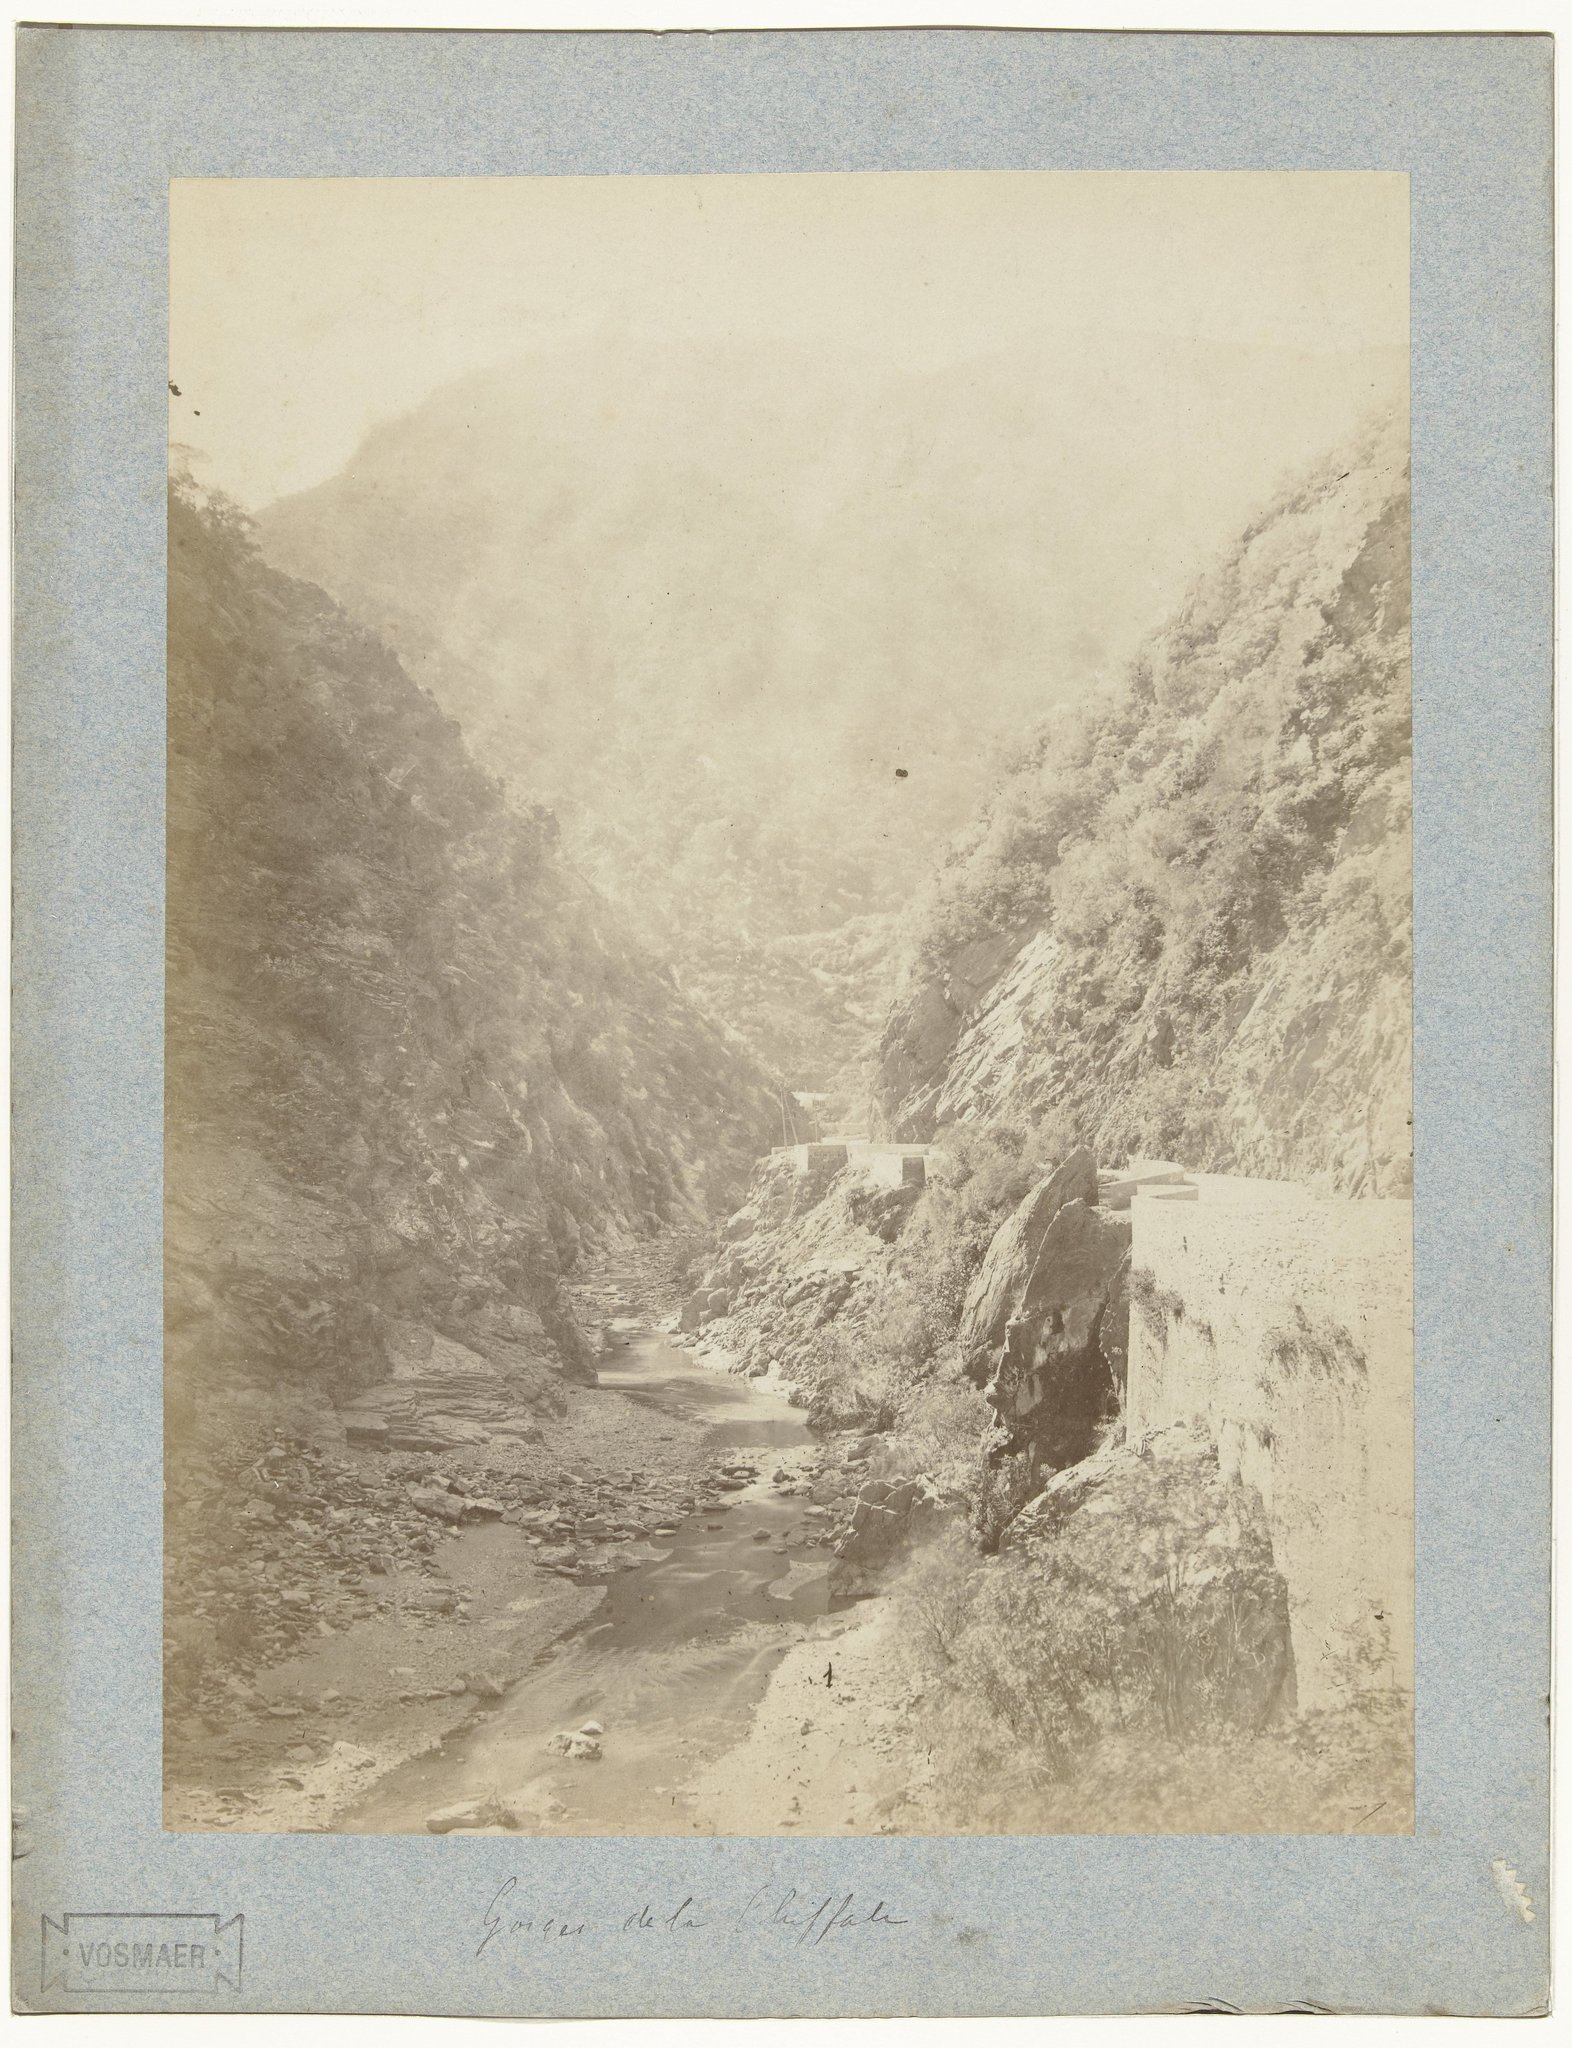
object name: photograph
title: Bergkloof bij Chiffa, Algerije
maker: Anonymous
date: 1860-1900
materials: cardboard, paper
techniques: albumen print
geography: chiffa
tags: river, mountains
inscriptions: collector's mark: ‘VOSMAER’